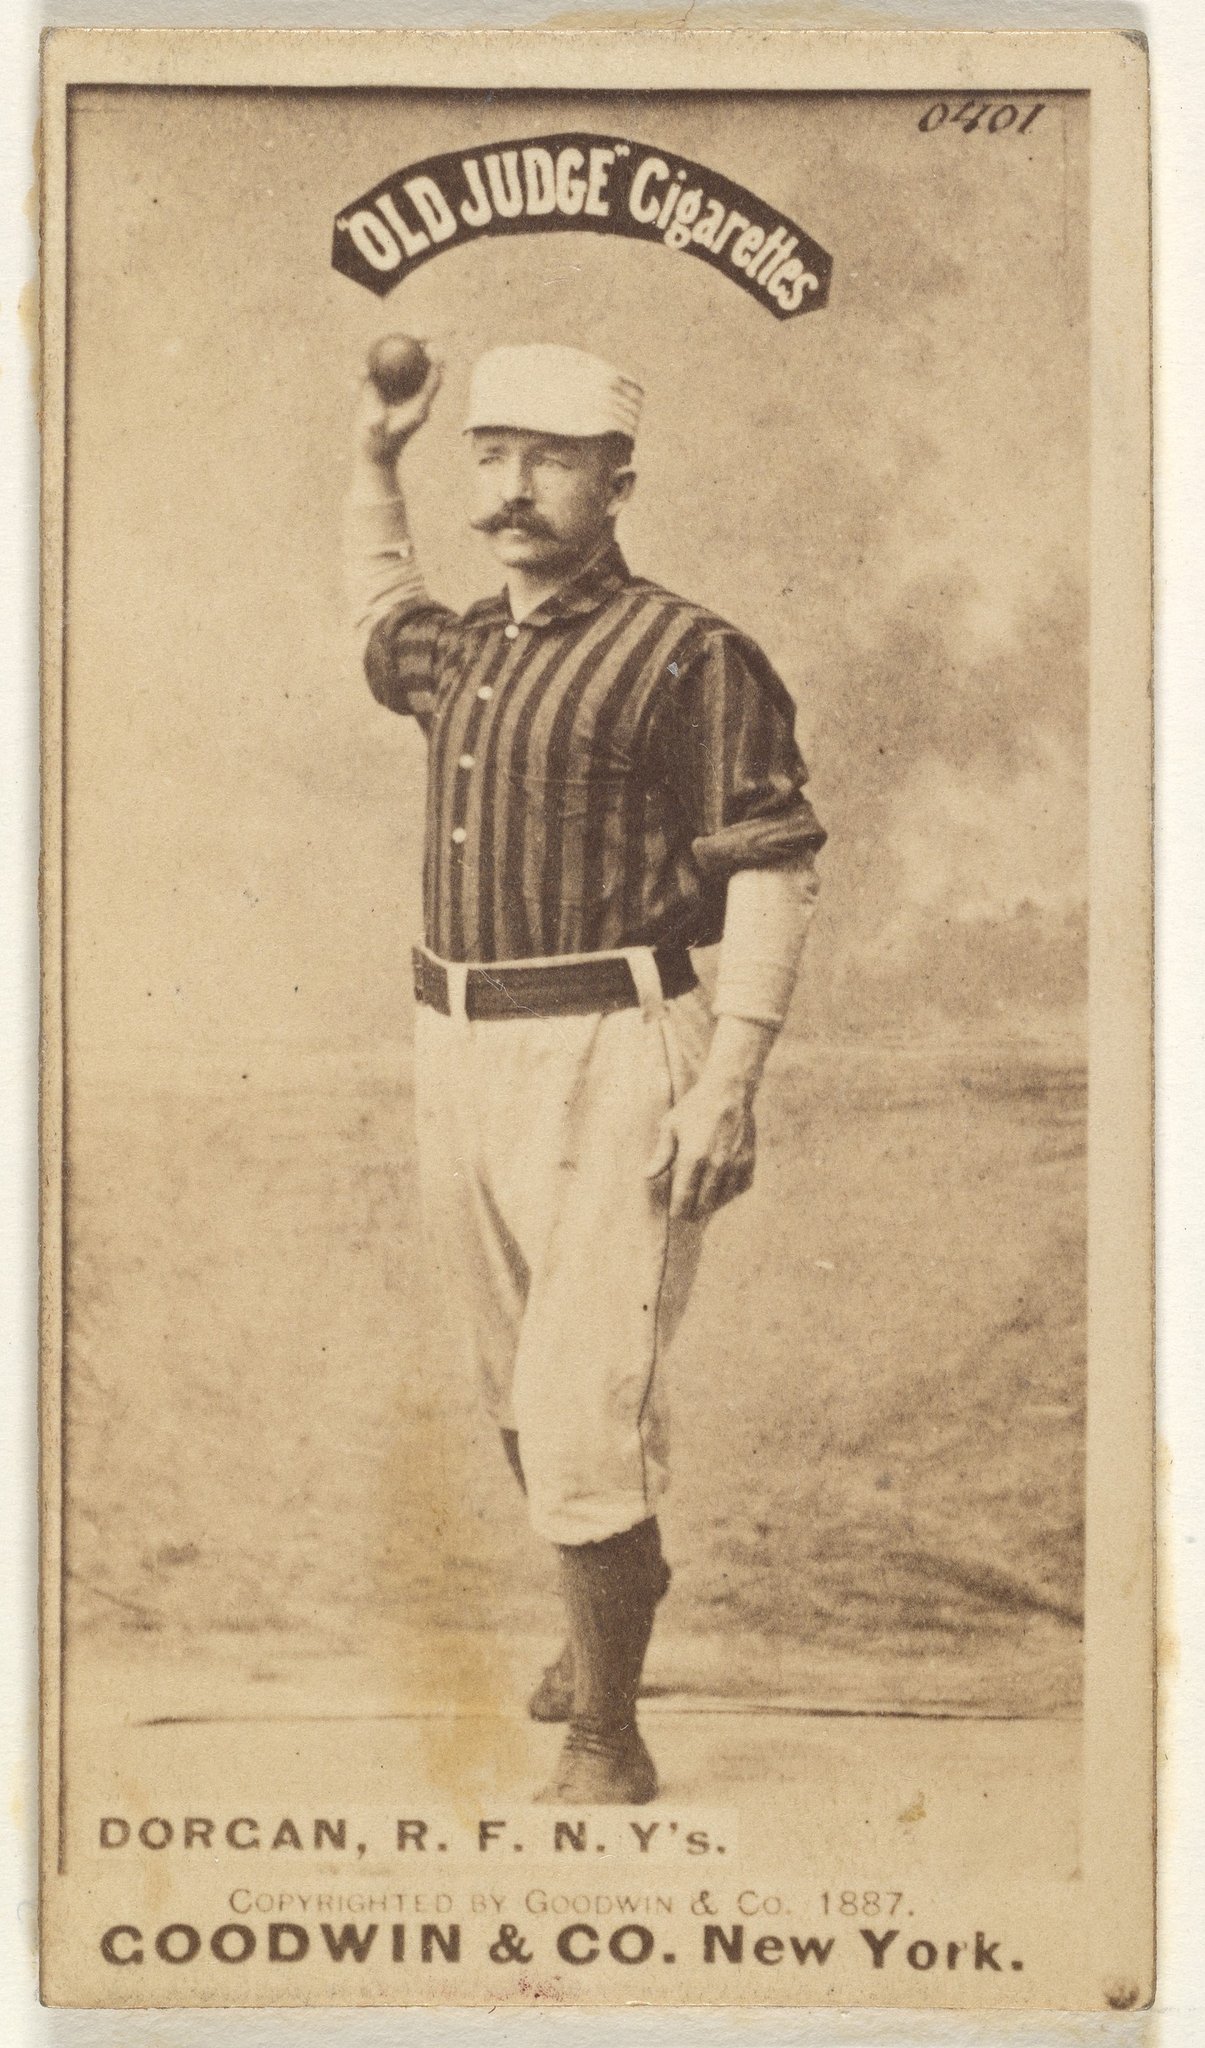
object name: baseball card, photograph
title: Michael Cornelius Dorgan, Right Field, New York, from the Old Judge series (N172) for Old Judge Cigarettes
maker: goodwin & company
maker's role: publisher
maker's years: 1850-1950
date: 1887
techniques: albumen silver print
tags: men,portraits,baseball,athletes